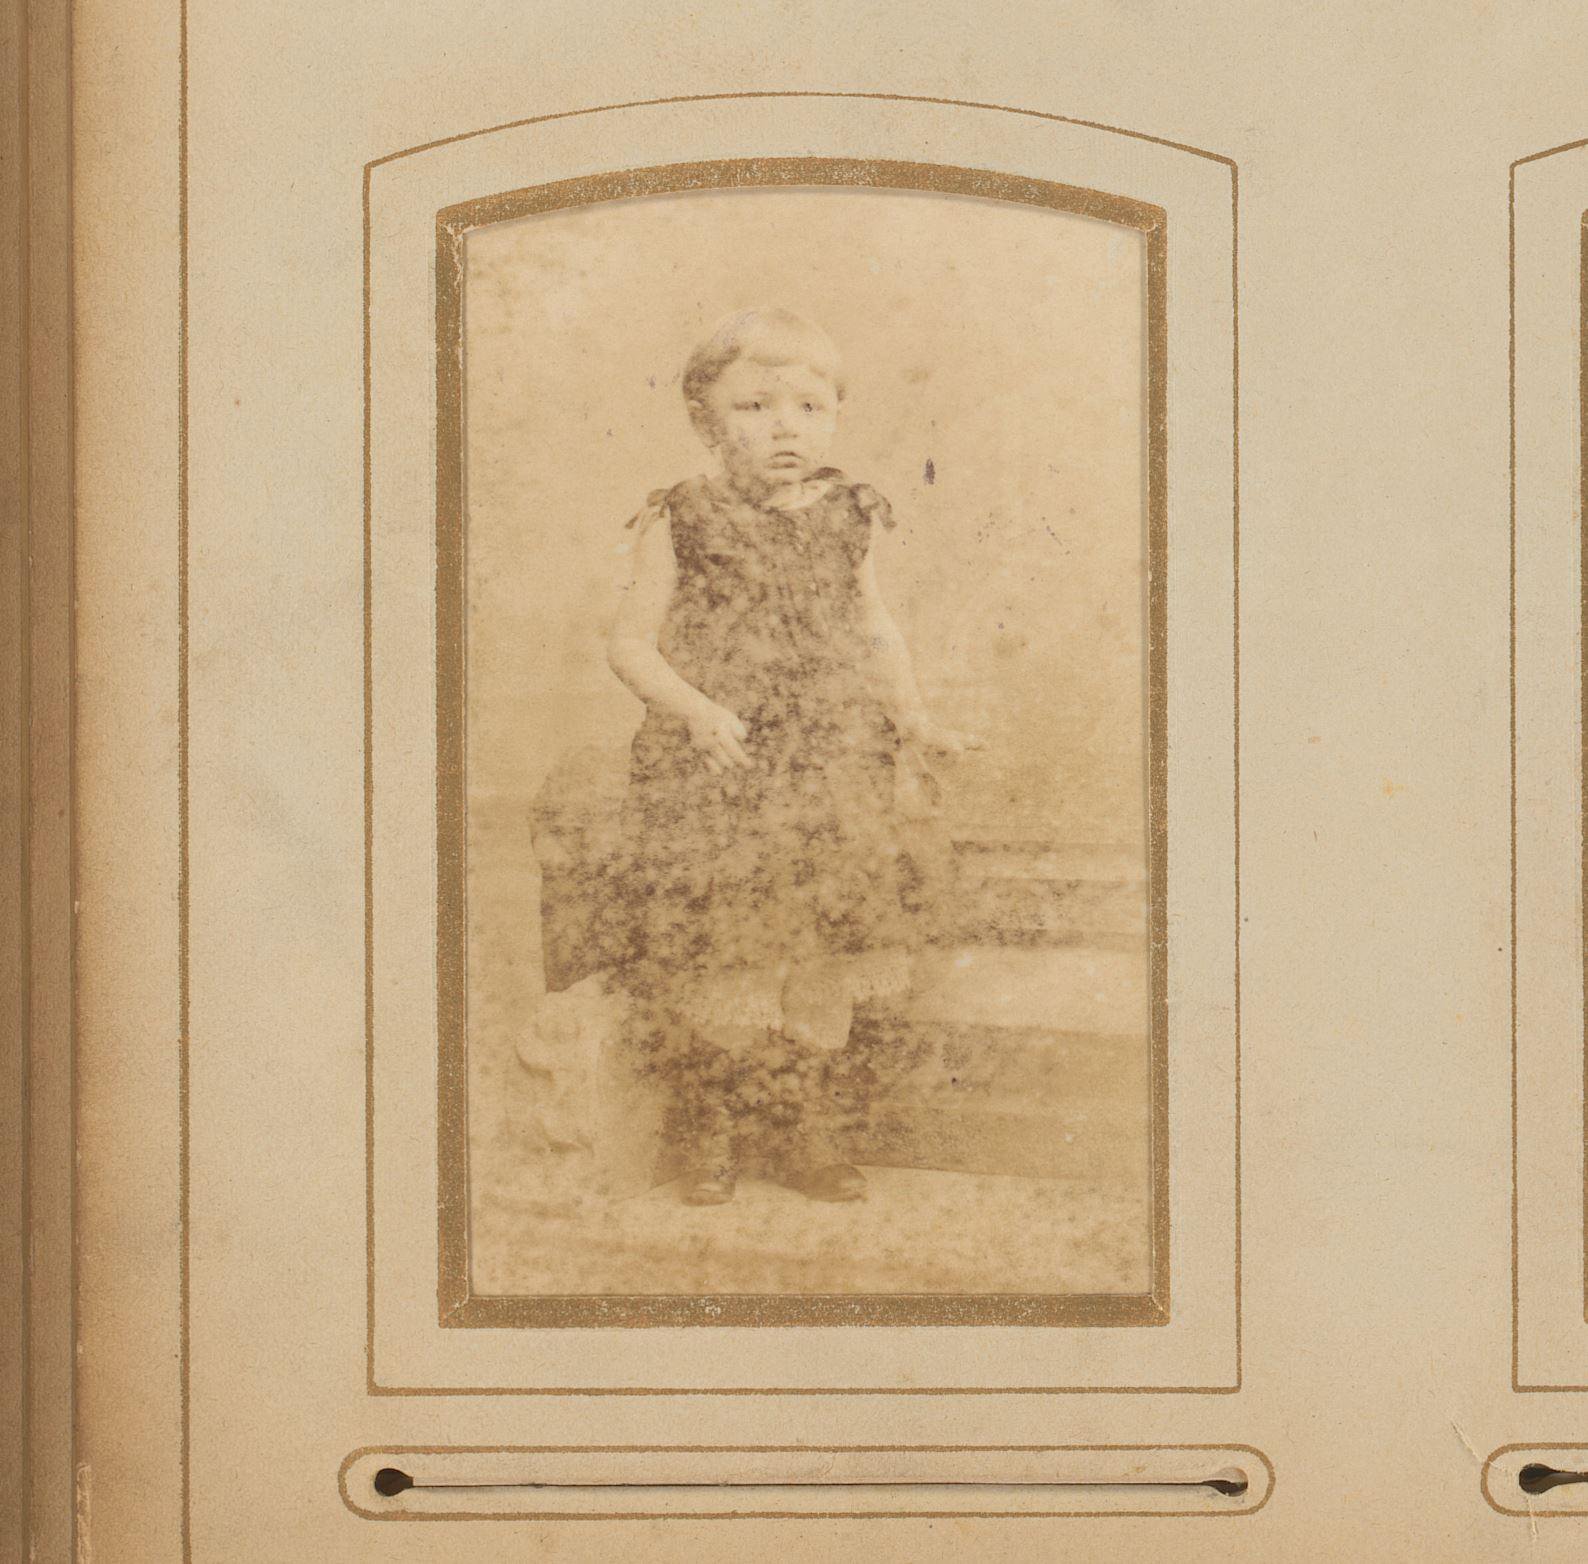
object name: album leaf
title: Portret van een kind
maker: august döpke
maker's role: fotograaf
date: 1860-1900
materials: cardboard, photographic support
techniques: albumen print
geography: bremen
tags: child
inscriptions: inscription: ‘Atelier für Photographie von/ August Döpke/ Bremen/ Birkenstrasse 11, parterre’